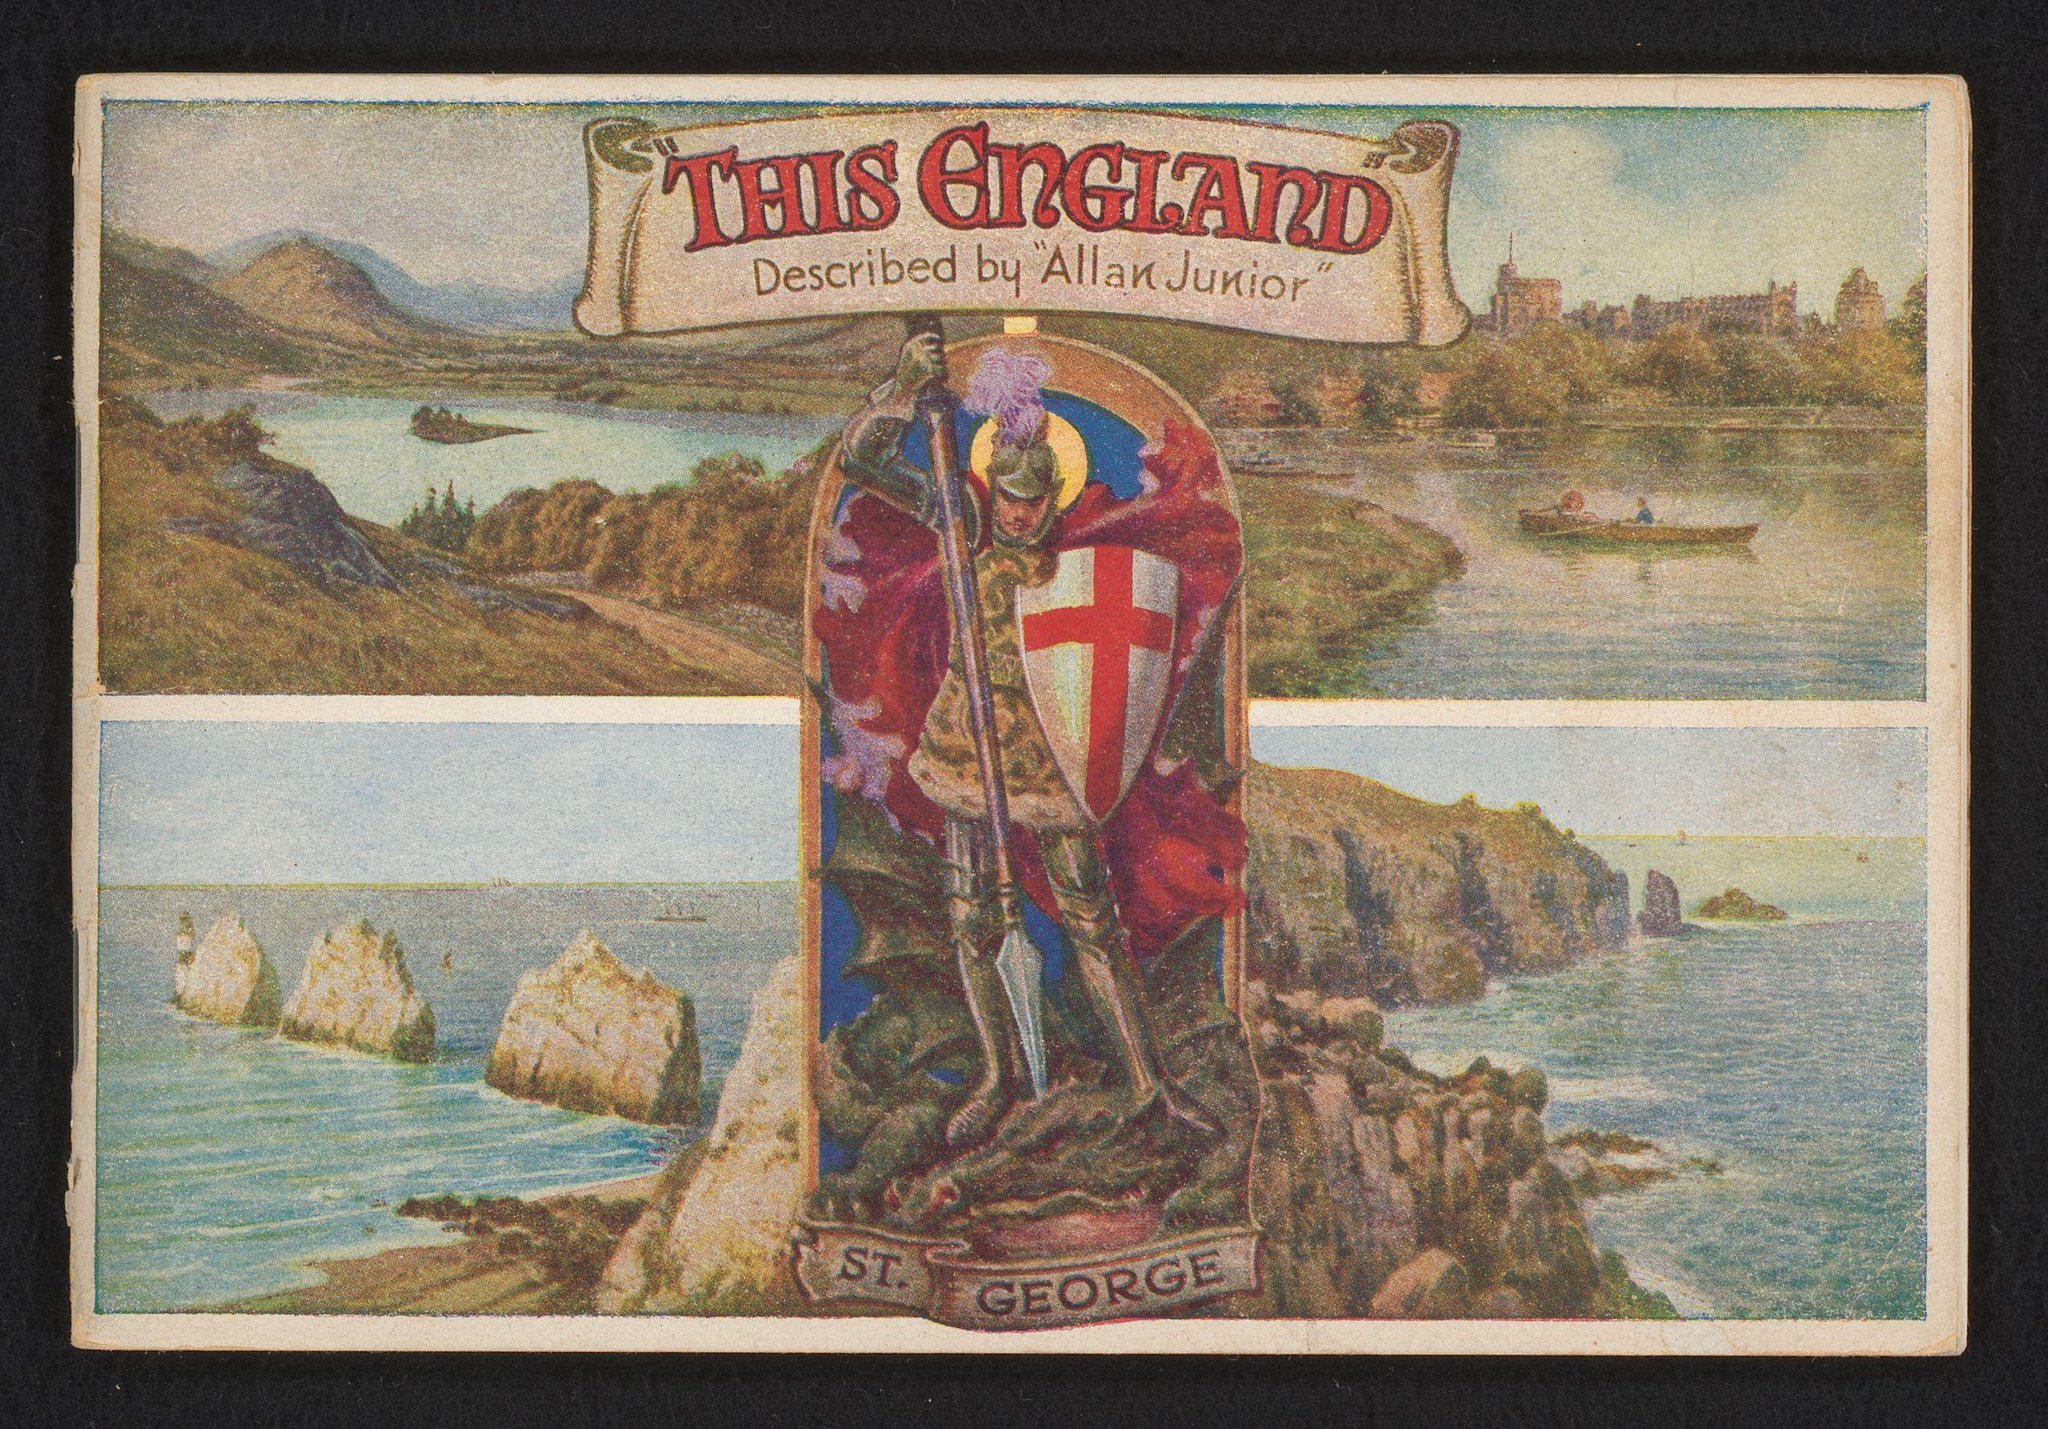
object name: photomechanical print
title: This England, described by "Allen Junior"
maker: Anonymous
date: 1900-1952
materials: paper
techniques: three-color autotype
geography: dundee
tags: city-view in general; 'veduta', england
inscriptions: inscription: ‘A Pictorial Memento of the scenic/ loveliness that lies within the land/ which the King calls/ "Our Own Dear Home."’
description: Souveniralbum met 62 gezichten op kastelen, dorpen en landschappen uit Engeland met begeleidende teksten van Allan Junior.